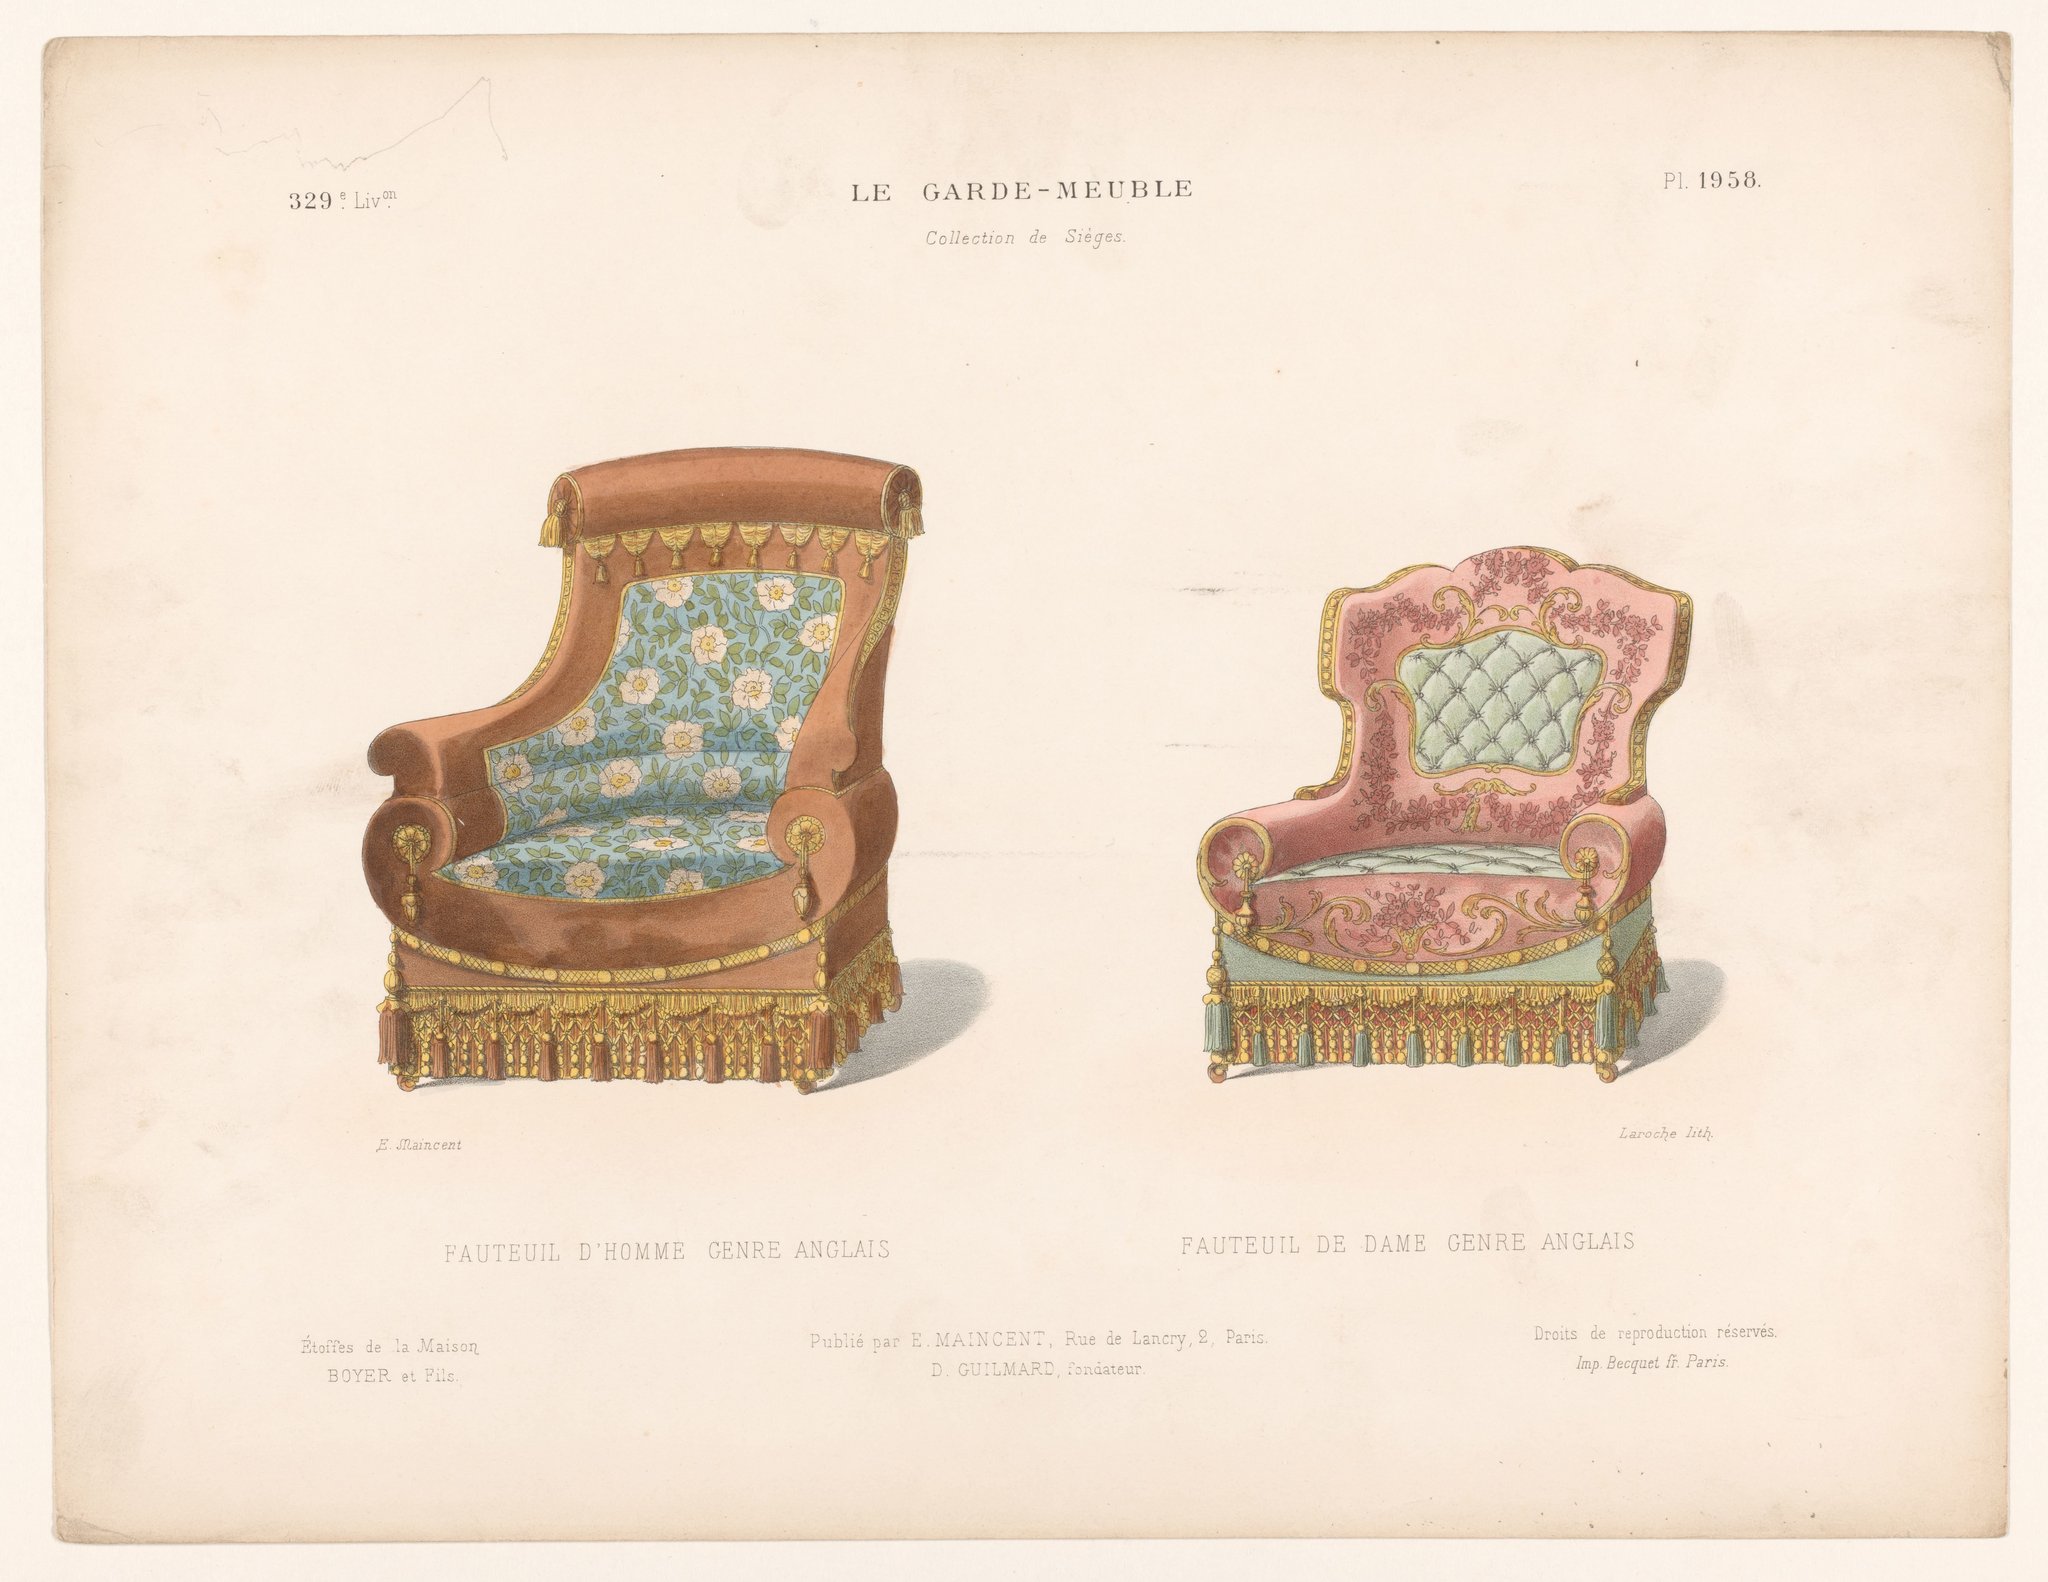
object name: print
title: Fauteuil d'homme genre Anglais / Fauteuil de dame genre Anglais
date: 1885-1895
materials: paper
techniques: hand coloring, lithograph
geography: paris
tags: seating furniture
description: Ieder Livraison in de serie Le Garde-Meuble bevat negen platen: drie 'sièges' (zitmeubels), drie 'meubles' (diverse meubels zoals tafels en kasten) en drie 'tentures' (gordijnen en draperieën).